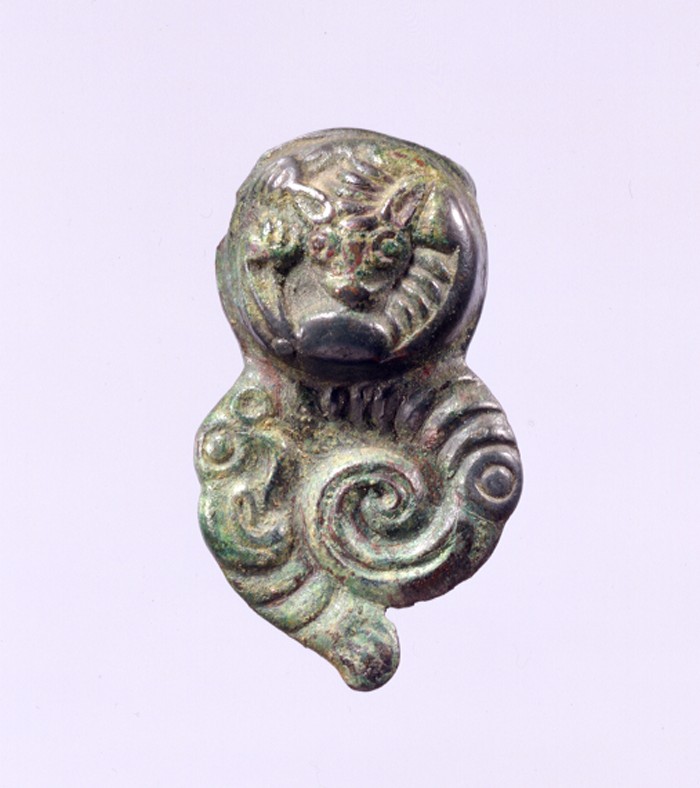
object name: harness ornament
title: Harness Ornament with Zoomorphic Motifs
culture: northwest chinese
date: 500-301 BCE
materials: bronze